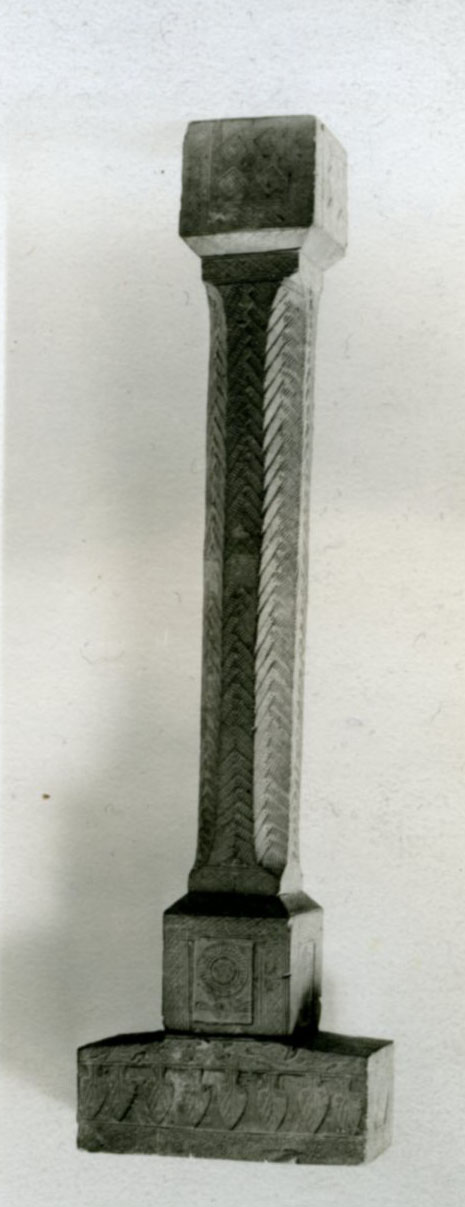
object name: tomb column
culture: chinese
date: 206 BCE-220 CE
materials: terracotta